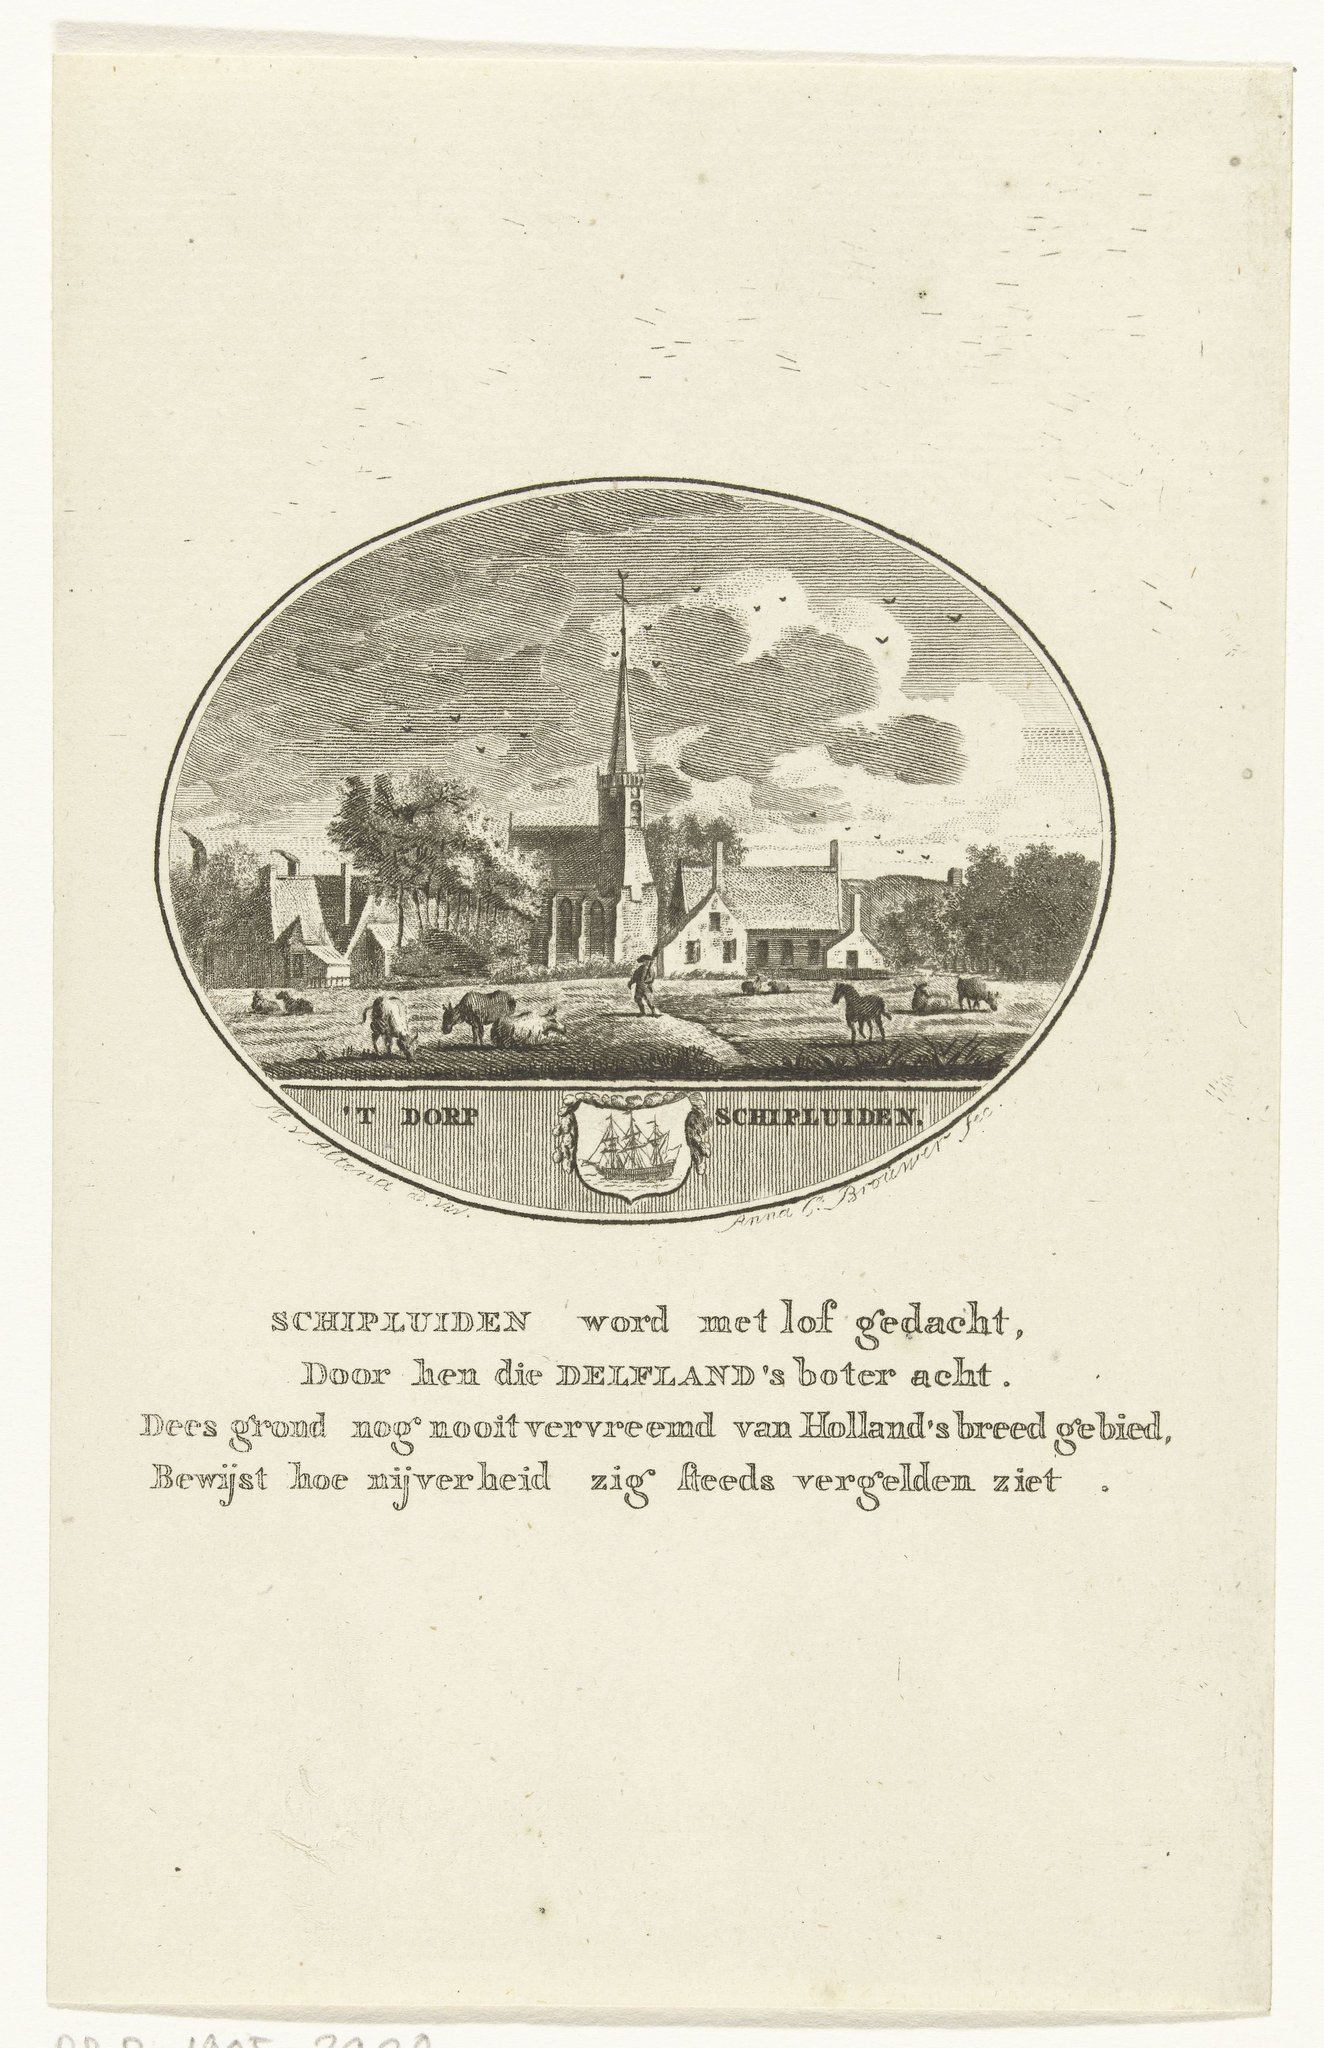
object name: book illustration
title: Gezicht op het dorp Schipluiden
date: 1791-1793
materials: paper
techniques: etching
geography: amsterdam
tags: city-view in general; 'veduta', village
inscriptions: collector's mark: Lugt 2228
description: afkomstig uit: L. van Ollefen, De Nederlandsche stad- en dorpbeschrijver. Deel 2. Amsterdam: H.A. Banse, 1793